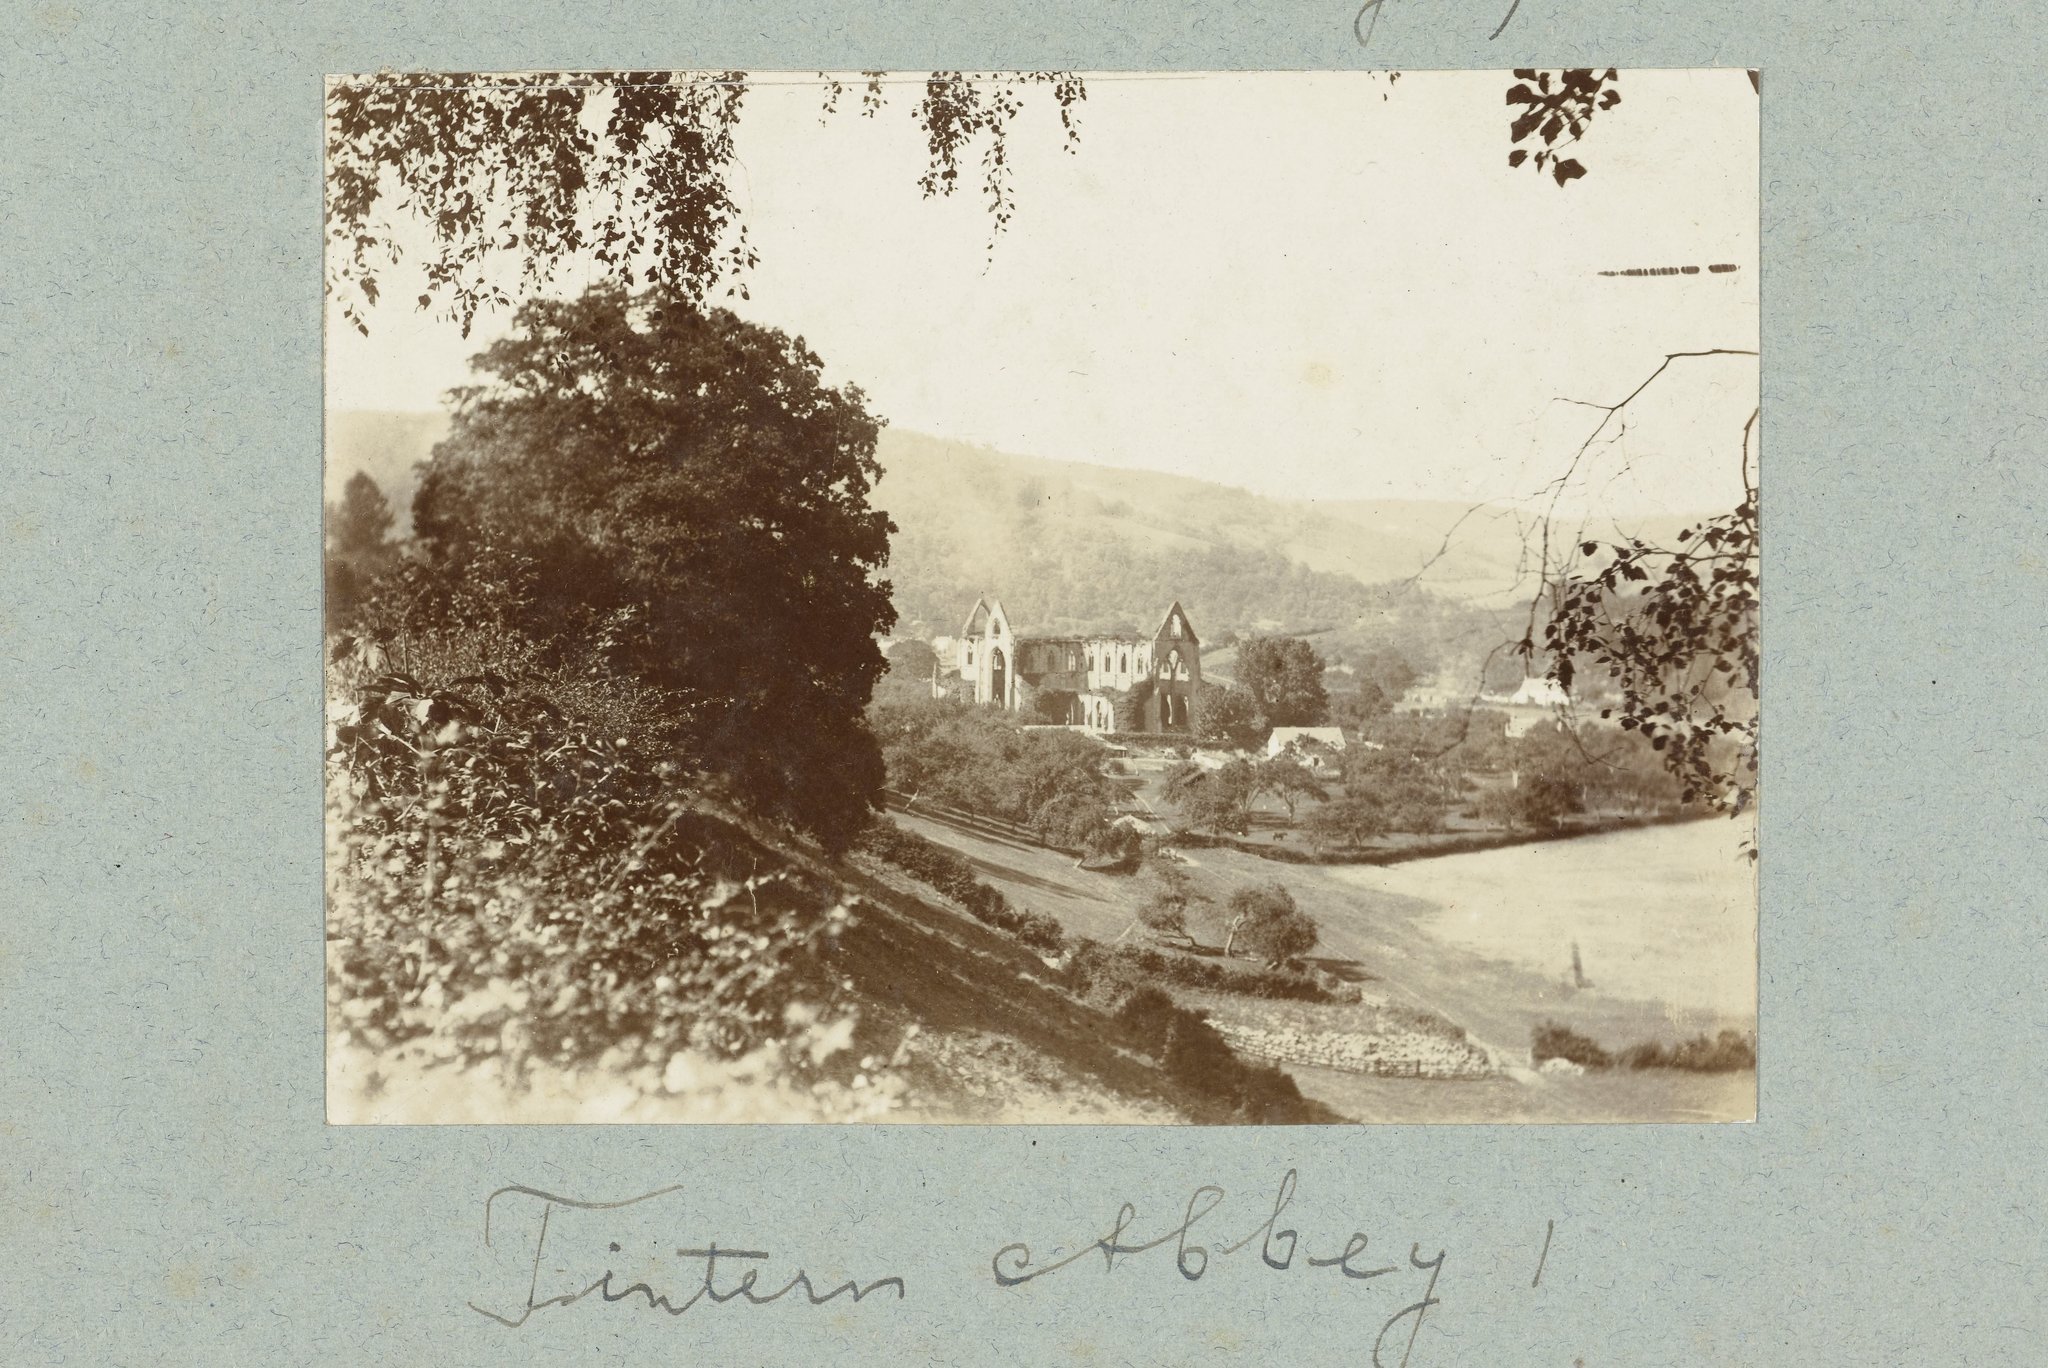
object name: photograph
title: Photographieën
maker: frits freerks fontein fz.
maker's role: fotograaf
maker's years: 1882-1928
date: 1901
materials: cardboard, paper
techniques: gelatin silver print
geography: england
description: Tintern Abbey is een ruine in Wales. Foto uit album 'Photographieën".